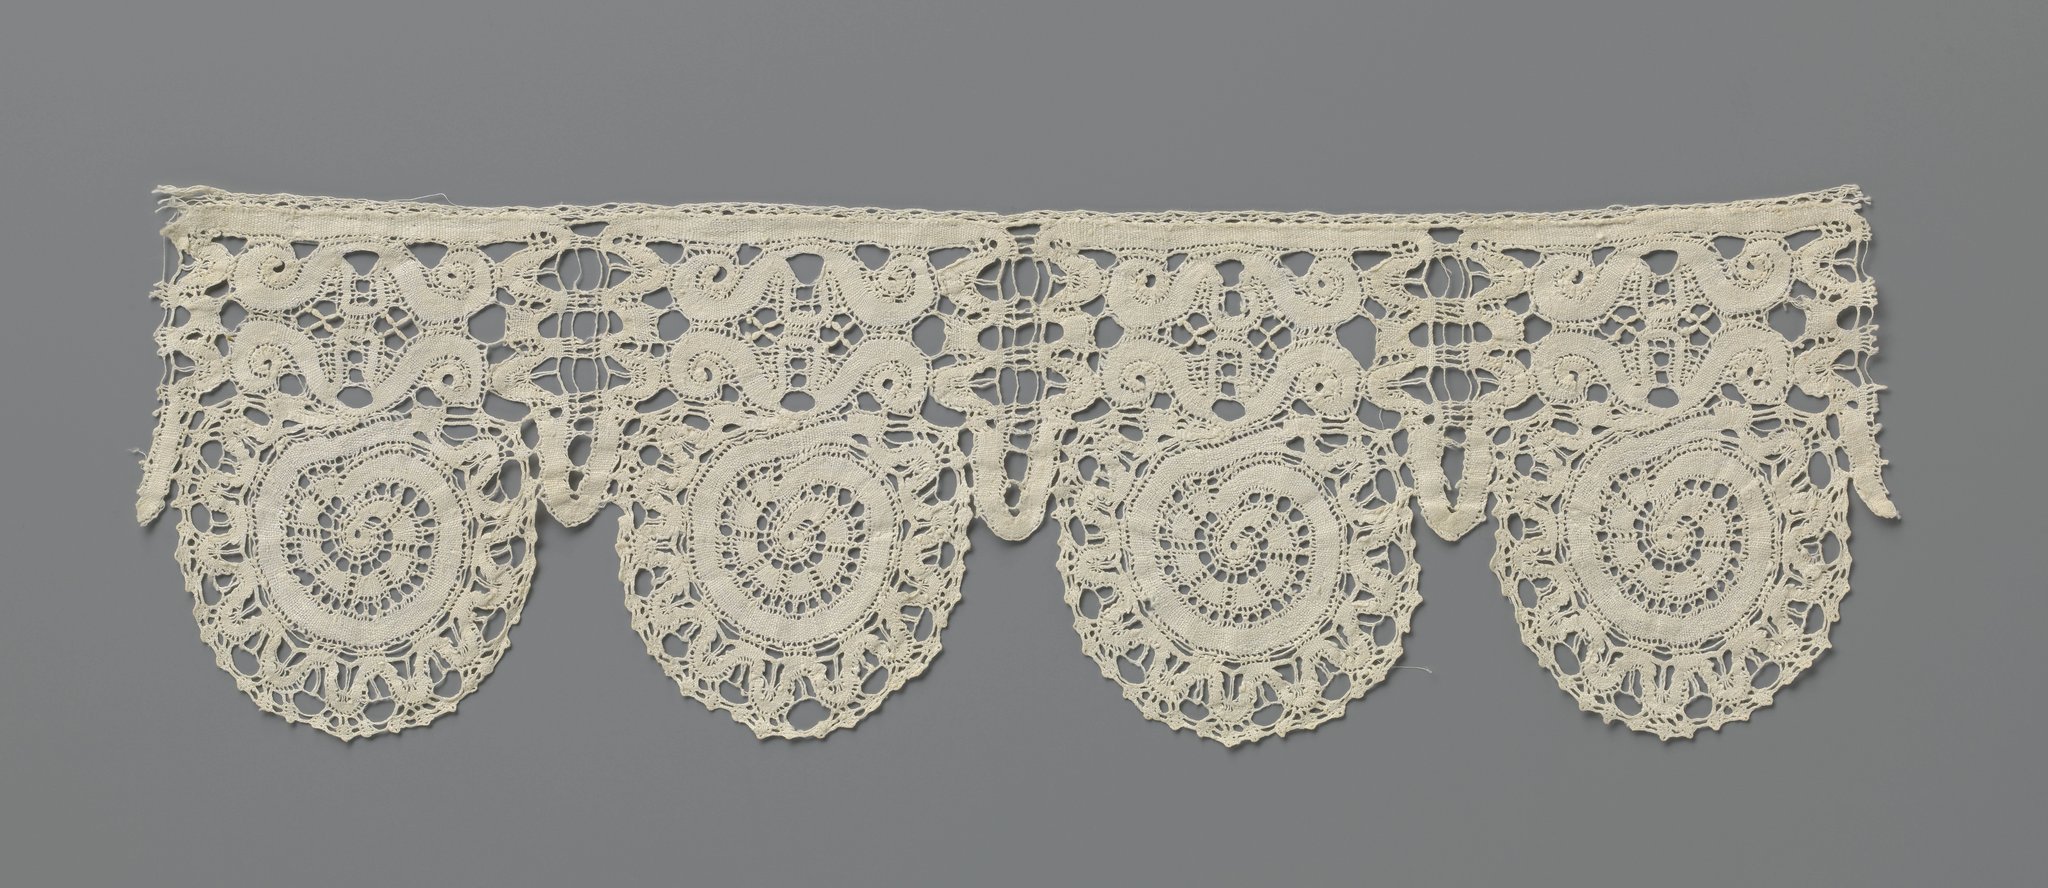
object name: strip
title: Strook kloskant met spiraal en gespiegelde voluten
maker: Anonymous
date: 1625-1649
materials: linen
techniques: lace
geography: tonderen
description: Strook naturelkleurige kloskant: oudvlaamse kloskant. Het zich herhalende en grotendeels symmetrische patroon bestaat uit een dubbele voluut, die over de breedte-as gespiegeld is en daaronder een halfronde schulp, die gevormd wordt door een spiraal. De motieven zijn gevormd door gekloste linten, gemaakt in linnenslag met opengewerkte randjes. De spiraal wordt door een regelmatig slingerend smaller lintje omringd. Tussen de gespiegelde voluten zijn kruisjes gemaakt met vormslagen. De motieven zijn door vlechtjes met elkaar verbonden. De bovenrand is afgewerkt met een apart geklost bandje.